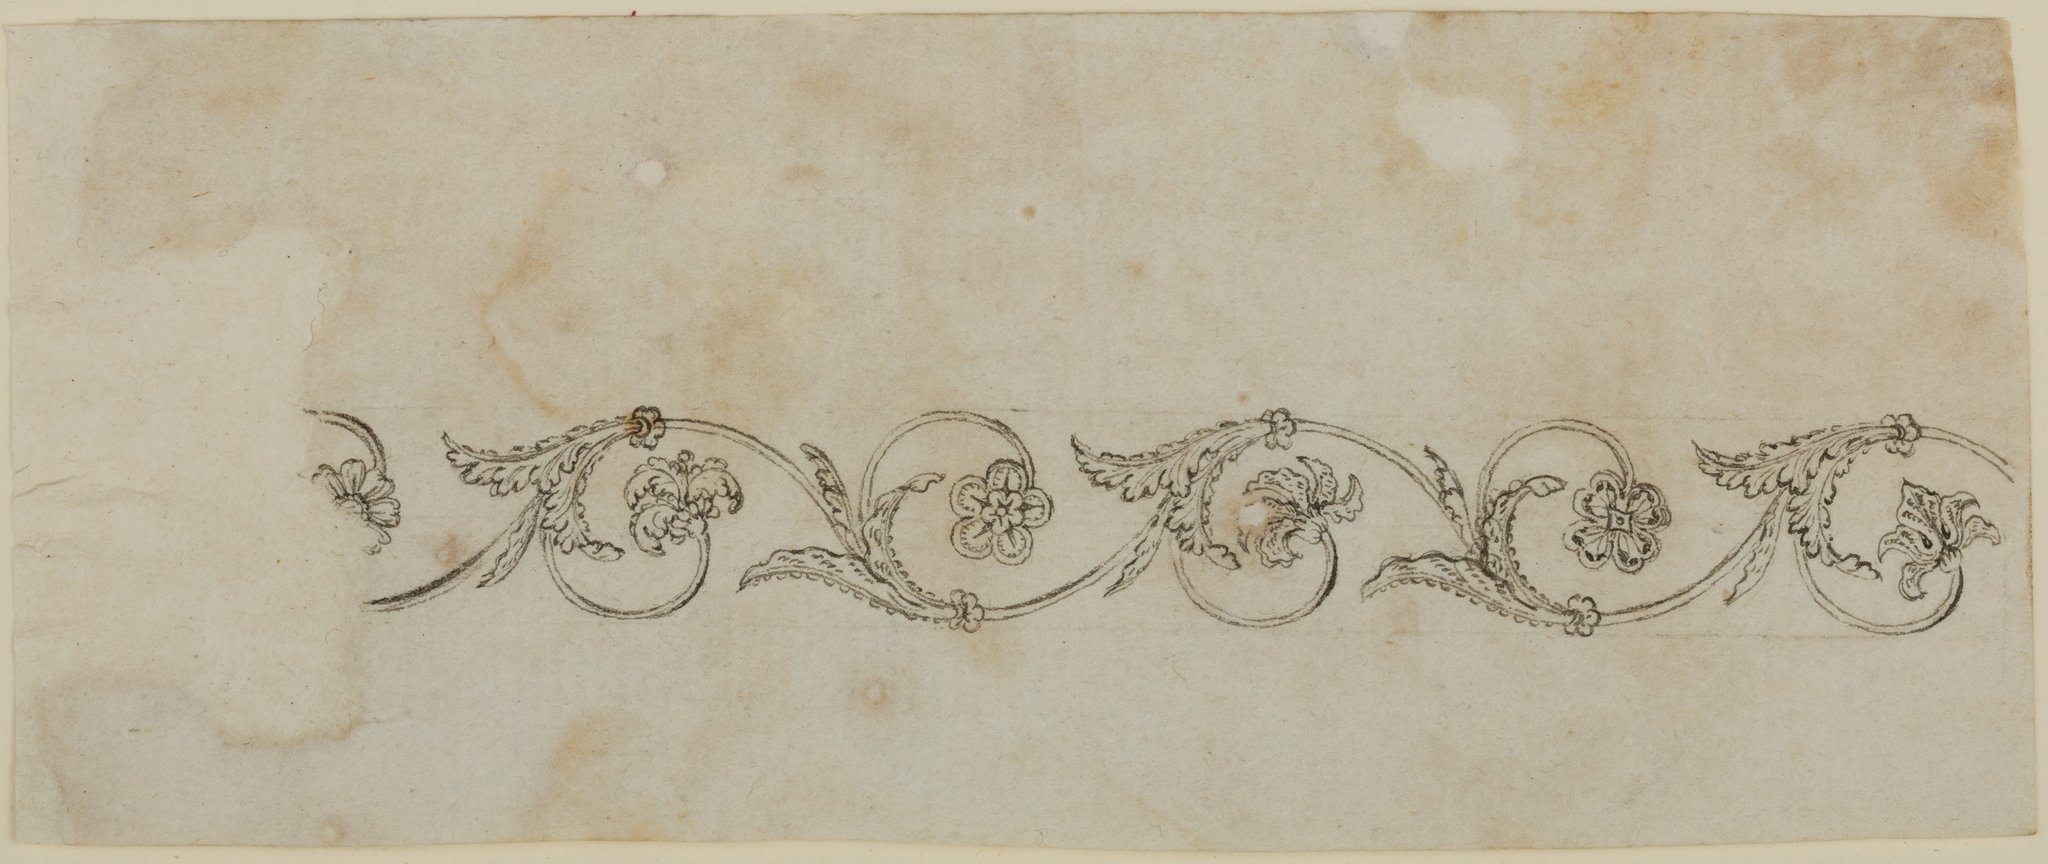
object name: drawing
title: Design for the Decoration of Firearms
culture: french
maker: nicolas noël boutet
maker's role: designer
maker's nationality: french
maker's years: 1761-1833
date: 1797-1805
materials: ink, paper, pencil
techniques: wash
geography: france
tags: ornament